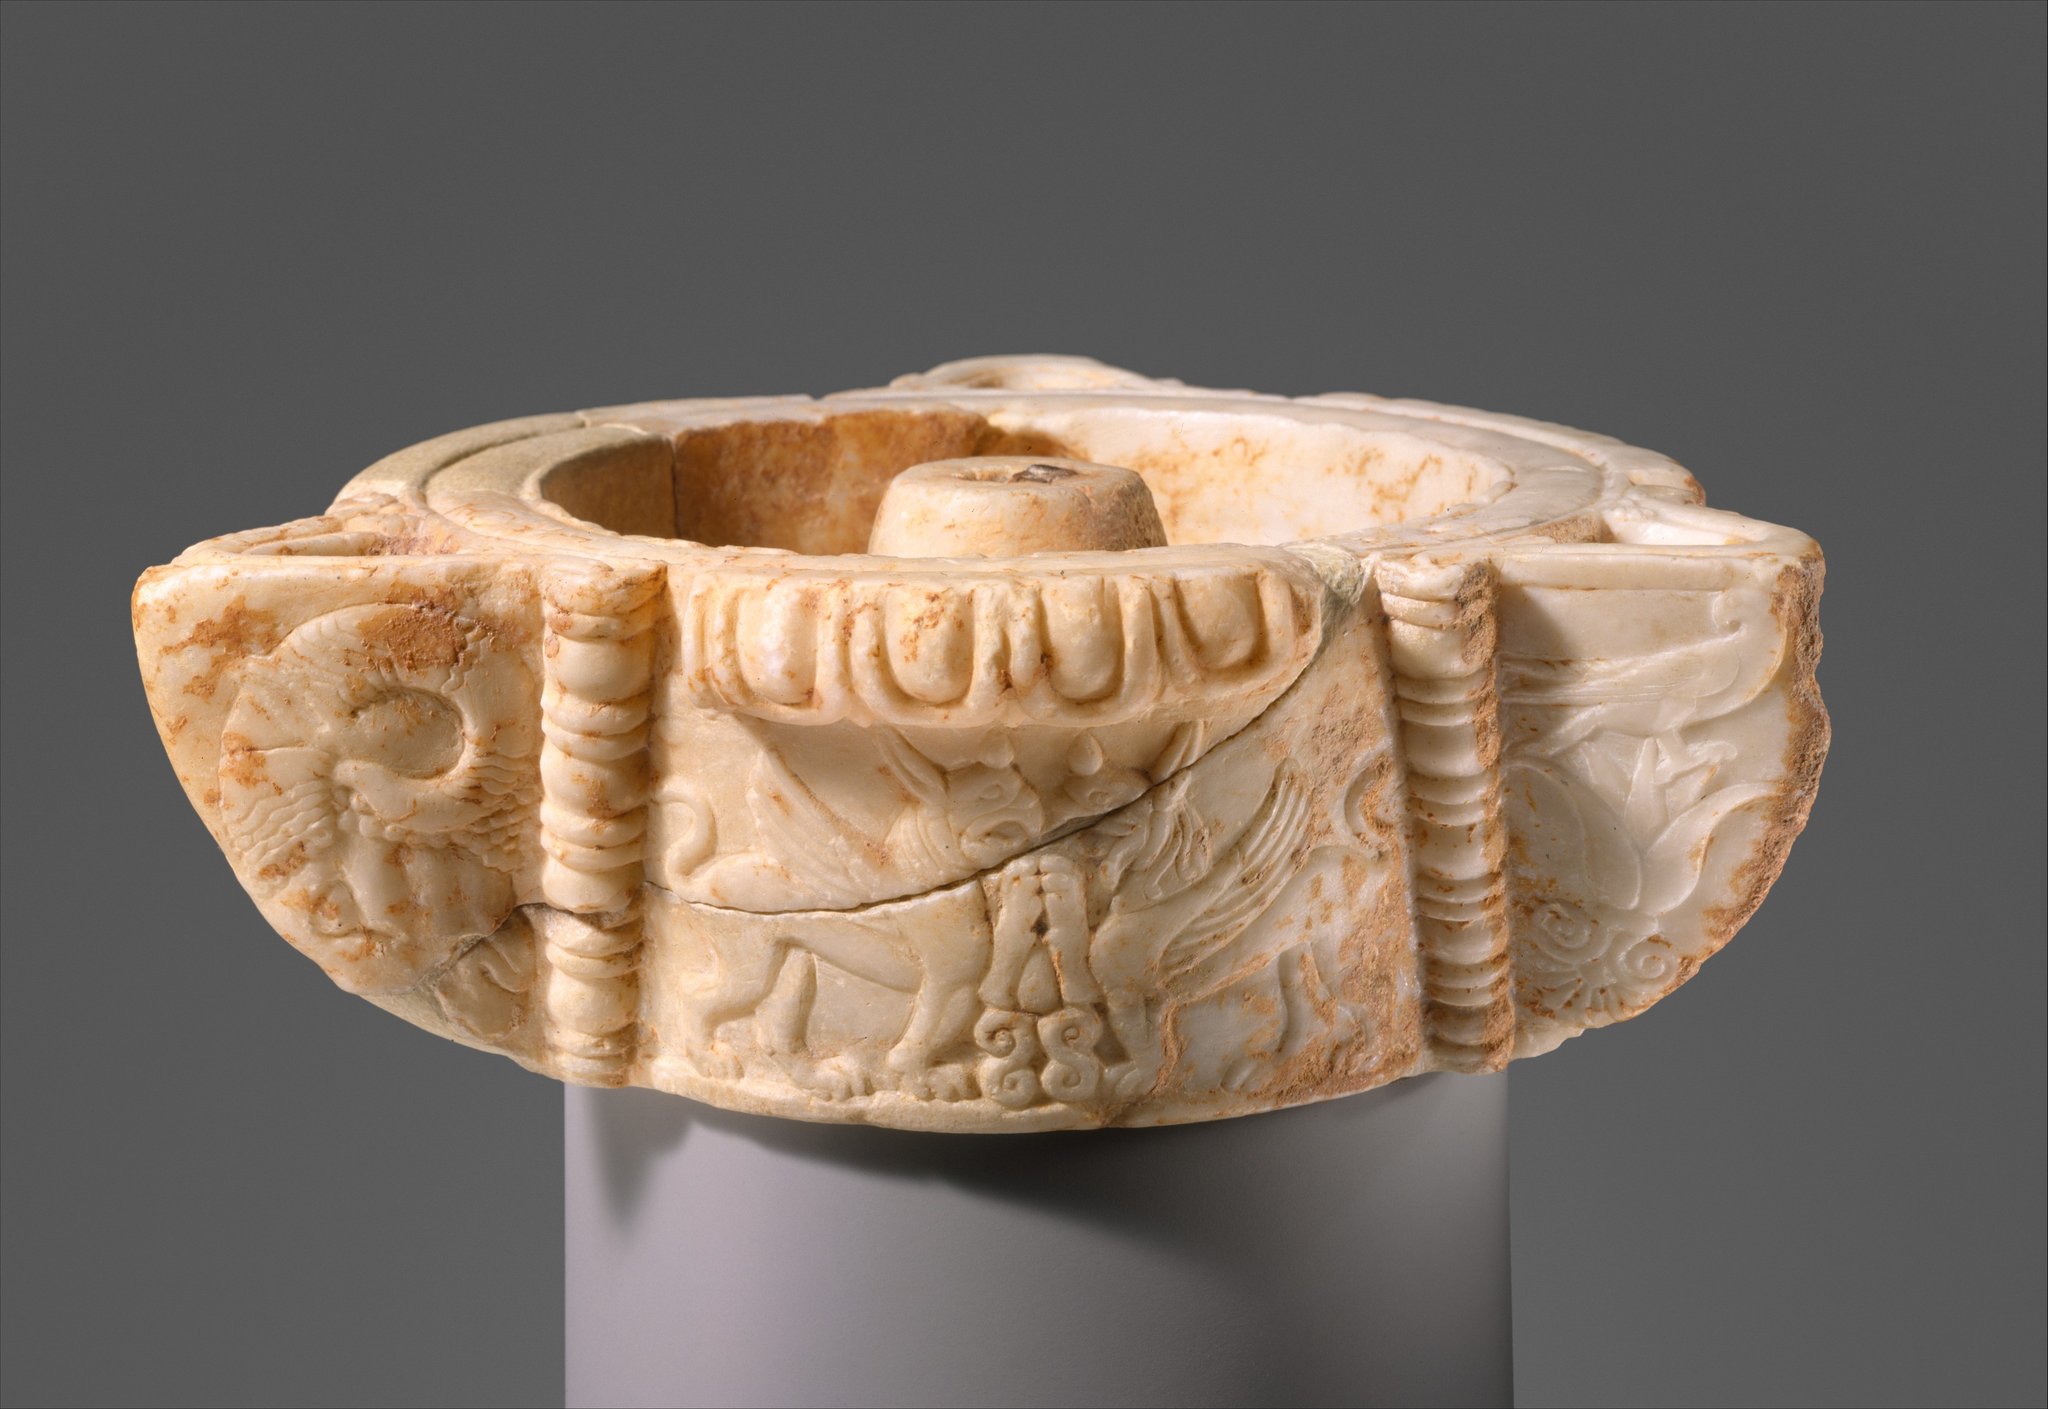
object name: lamp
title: Marble lamp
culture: greek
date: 600-501 BCE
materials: marble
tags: birds,griffins